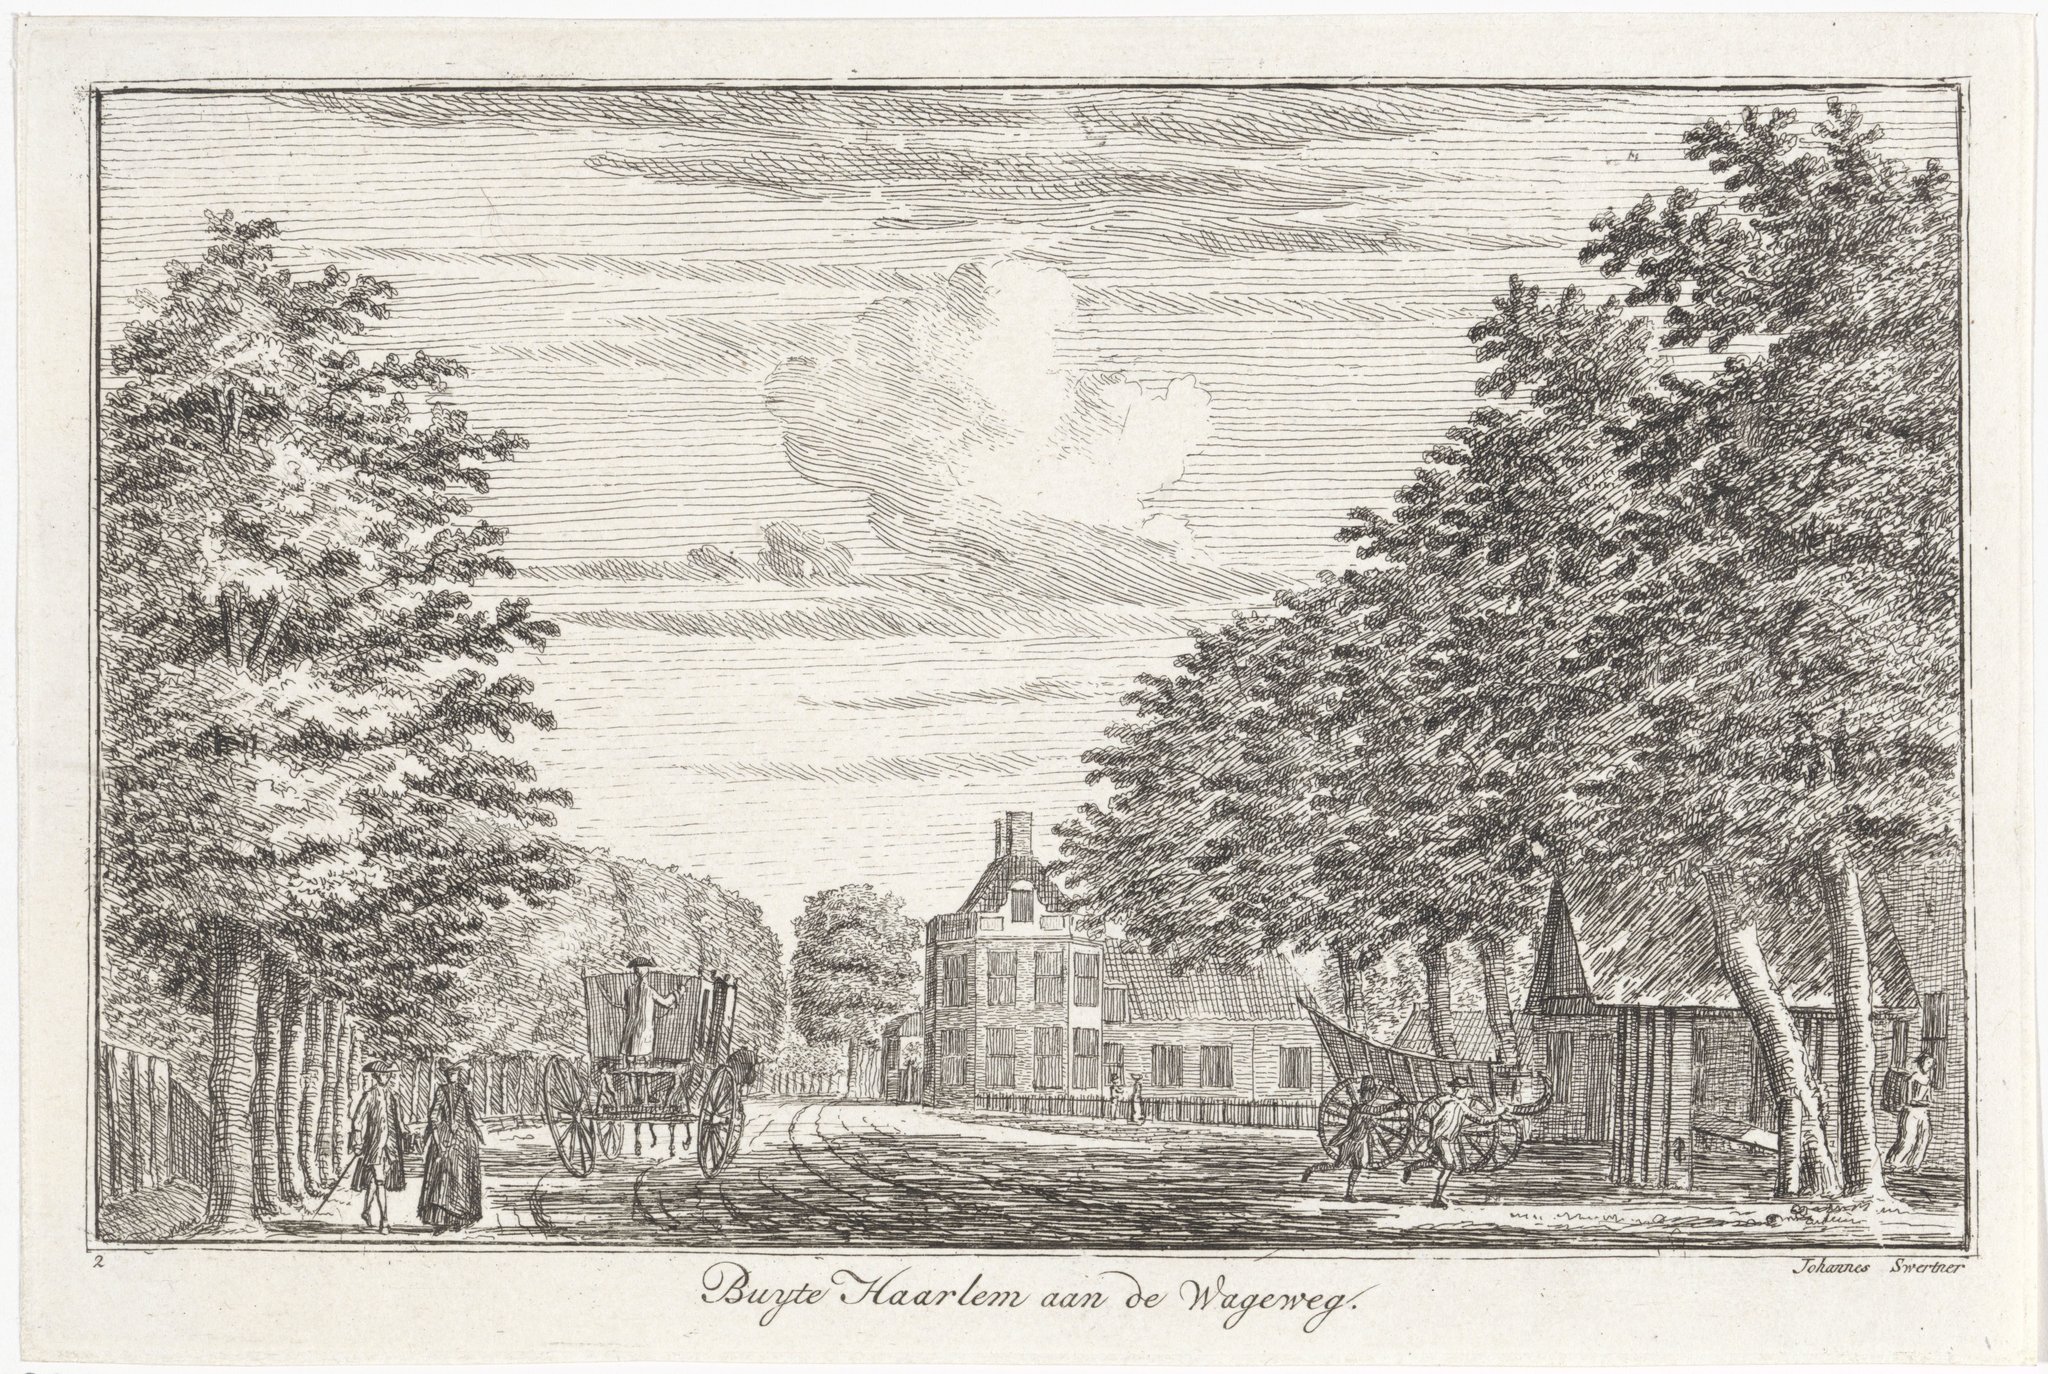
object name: print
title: Gezicht op de Wagenweg in Haarlem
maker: johannes swertner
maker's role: draughtsman, painter, print maker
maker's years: 1746-1813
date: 1763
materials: paper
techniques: etching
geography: haarlem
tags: four-wheeled, animal-drawn vehicle, e.g.: cab, carriage, coach, haarlem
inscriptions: collector's mark: Lugt 2228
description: Een koets rijdt over een weg waarlangs hoge bomen staan. Een dame en heer wandelen langs de weg. Aan het einde van de weg zicht op een statig huis. Rechtsonder rennen twee jongens achter elkaar aan. Linksonder genummerd "2".